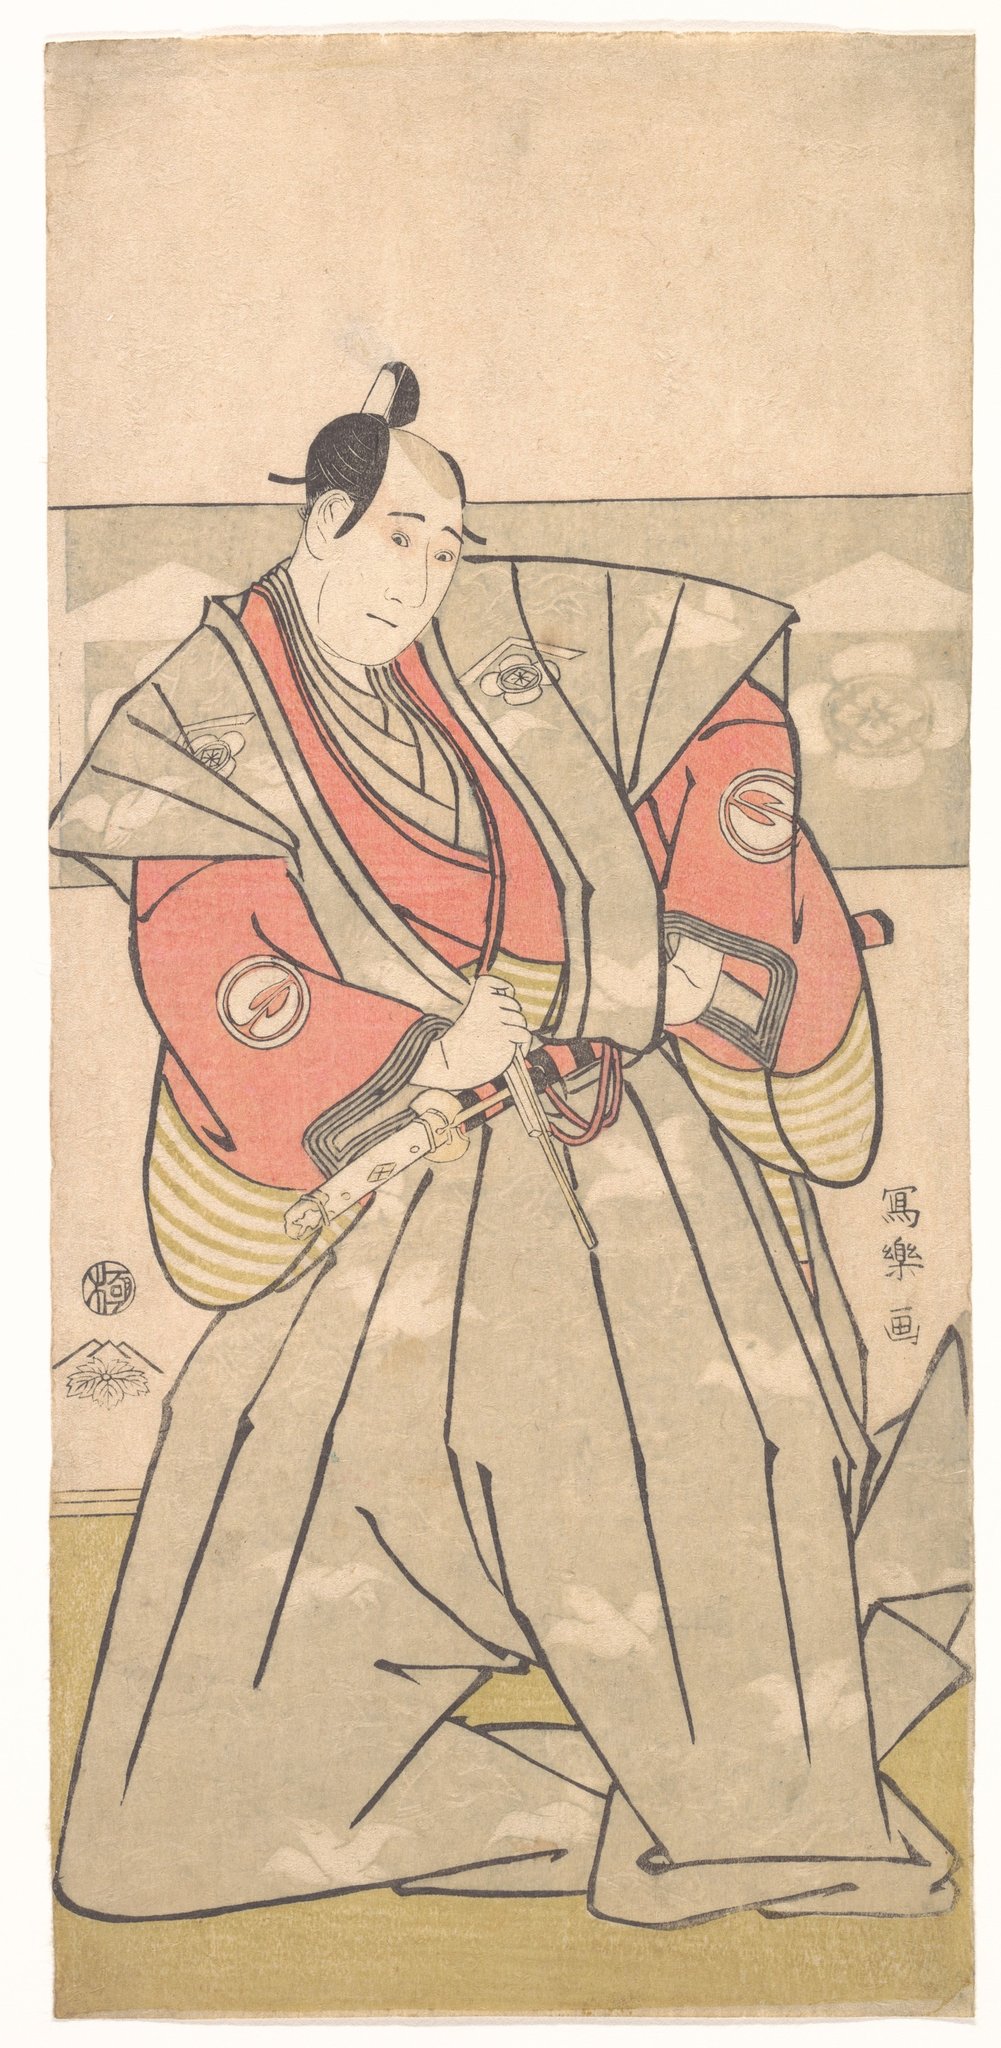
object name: print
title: The Actor Sawamura Sojuro III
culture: japanese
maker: tōshūsai sharaku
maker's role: artist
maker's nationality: japanese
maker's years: 1794-1795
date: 1794-1795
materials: ink, paper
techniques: woodblock print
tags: men,actors